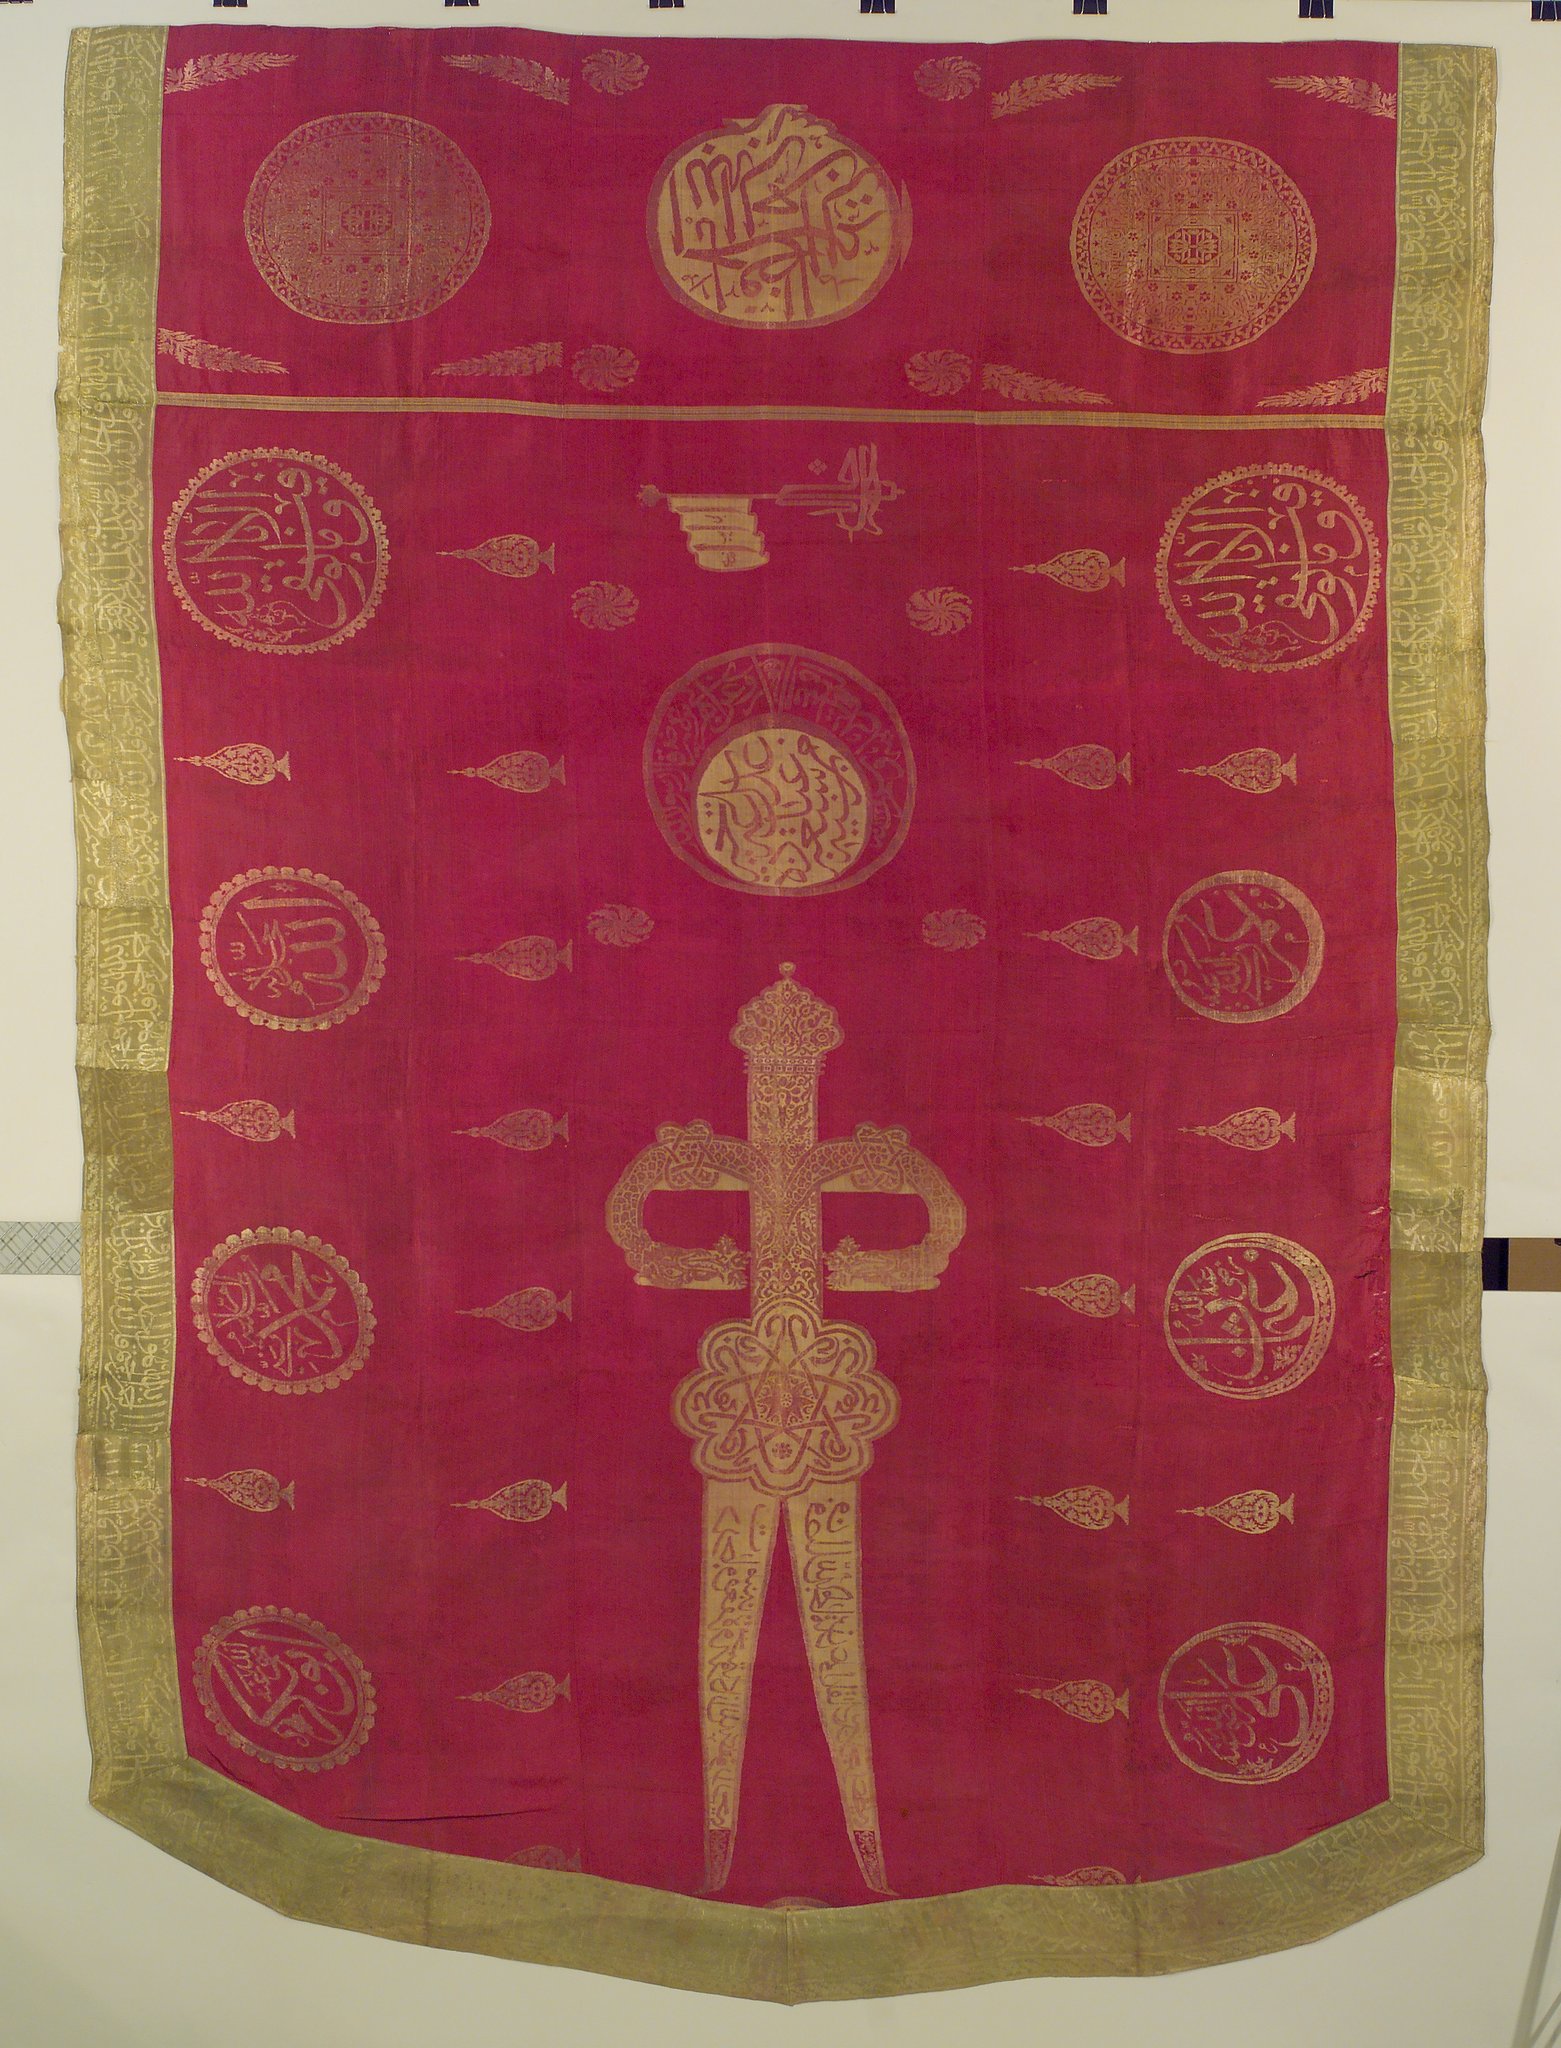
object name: banner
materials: metal thread, silk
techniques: brocade, lampas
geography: turkey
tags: swords